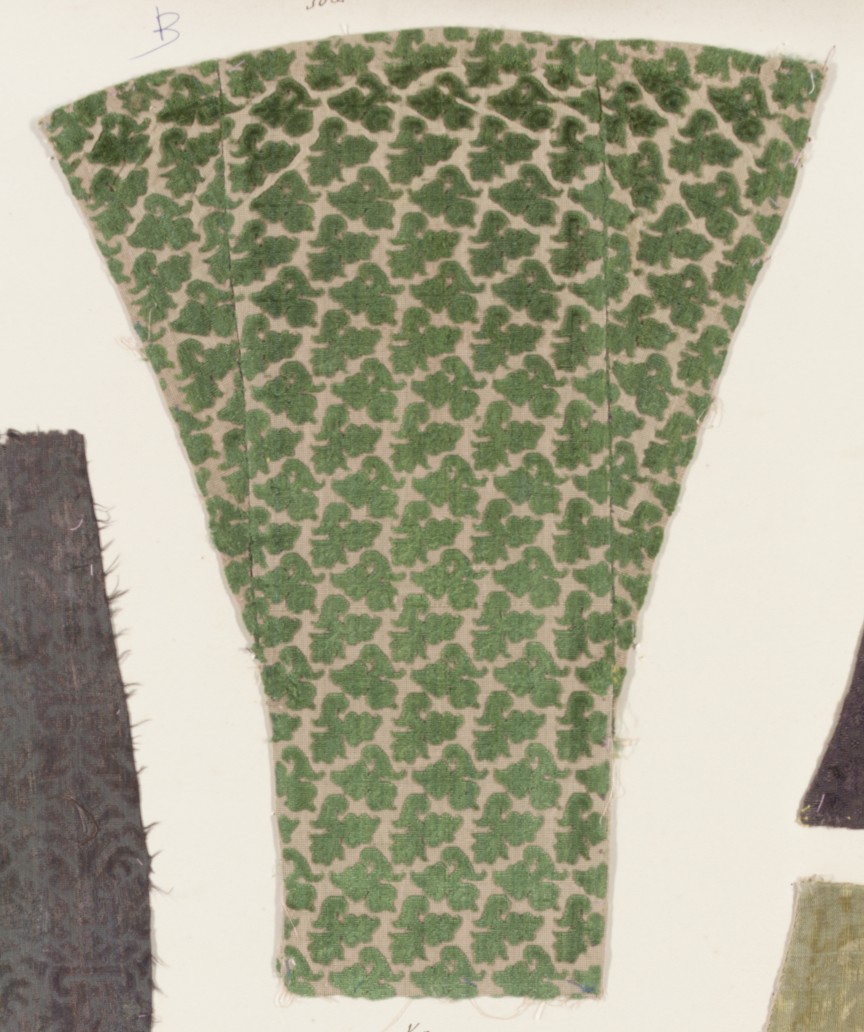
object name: fragment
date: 1501-1600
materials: silk